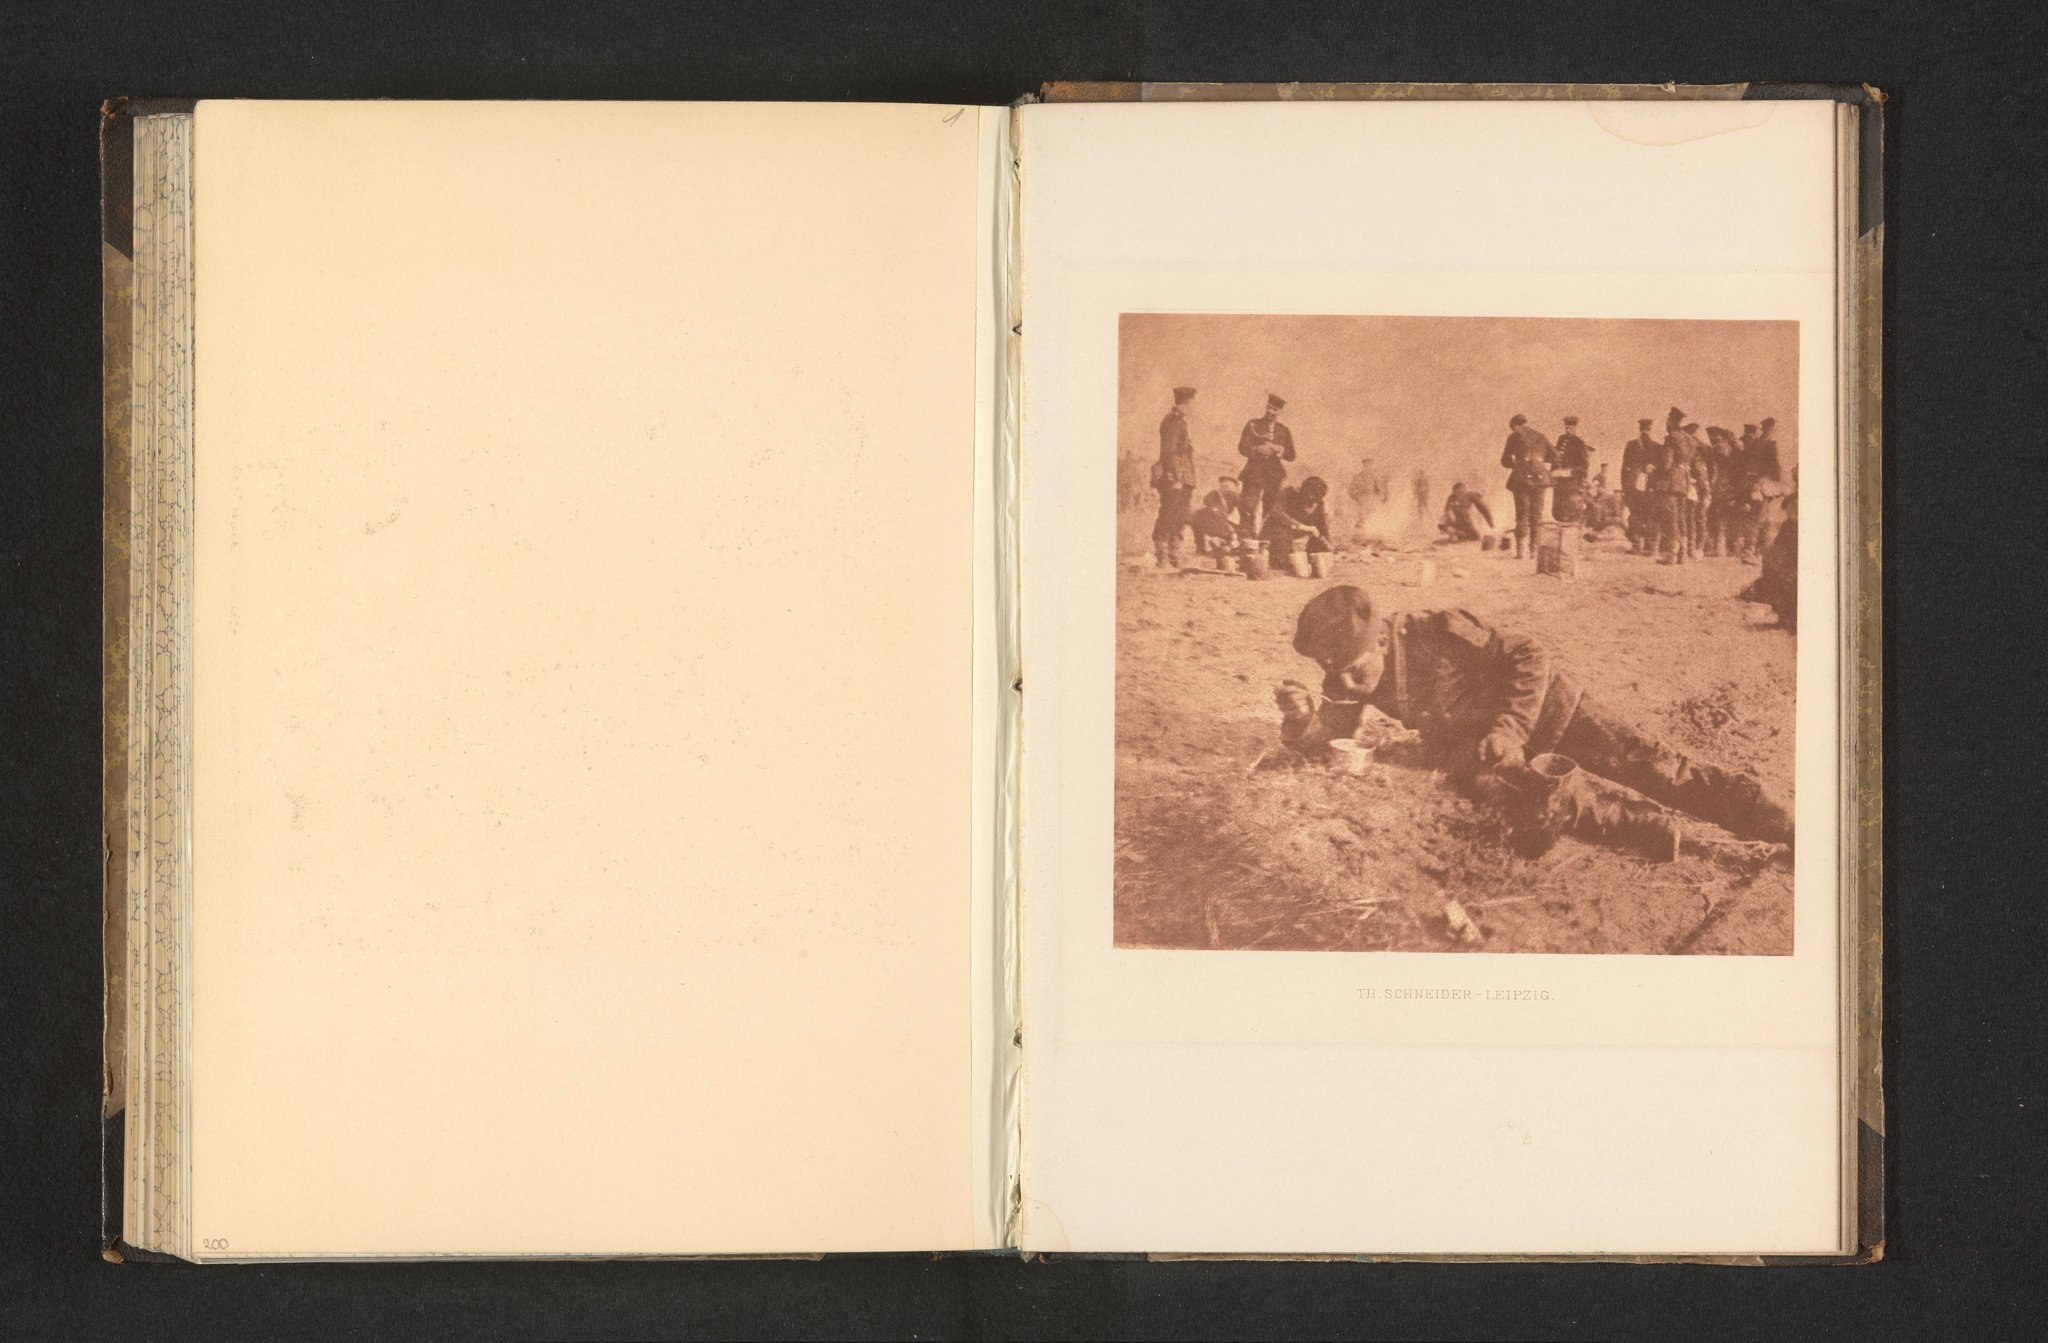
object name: photomechanical print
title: Half-liggend etende soldaat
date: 1898-1903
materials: paper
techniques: photoaquatint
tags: private soldier, eating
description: Prent twee van veertien prenten achterin het boek.